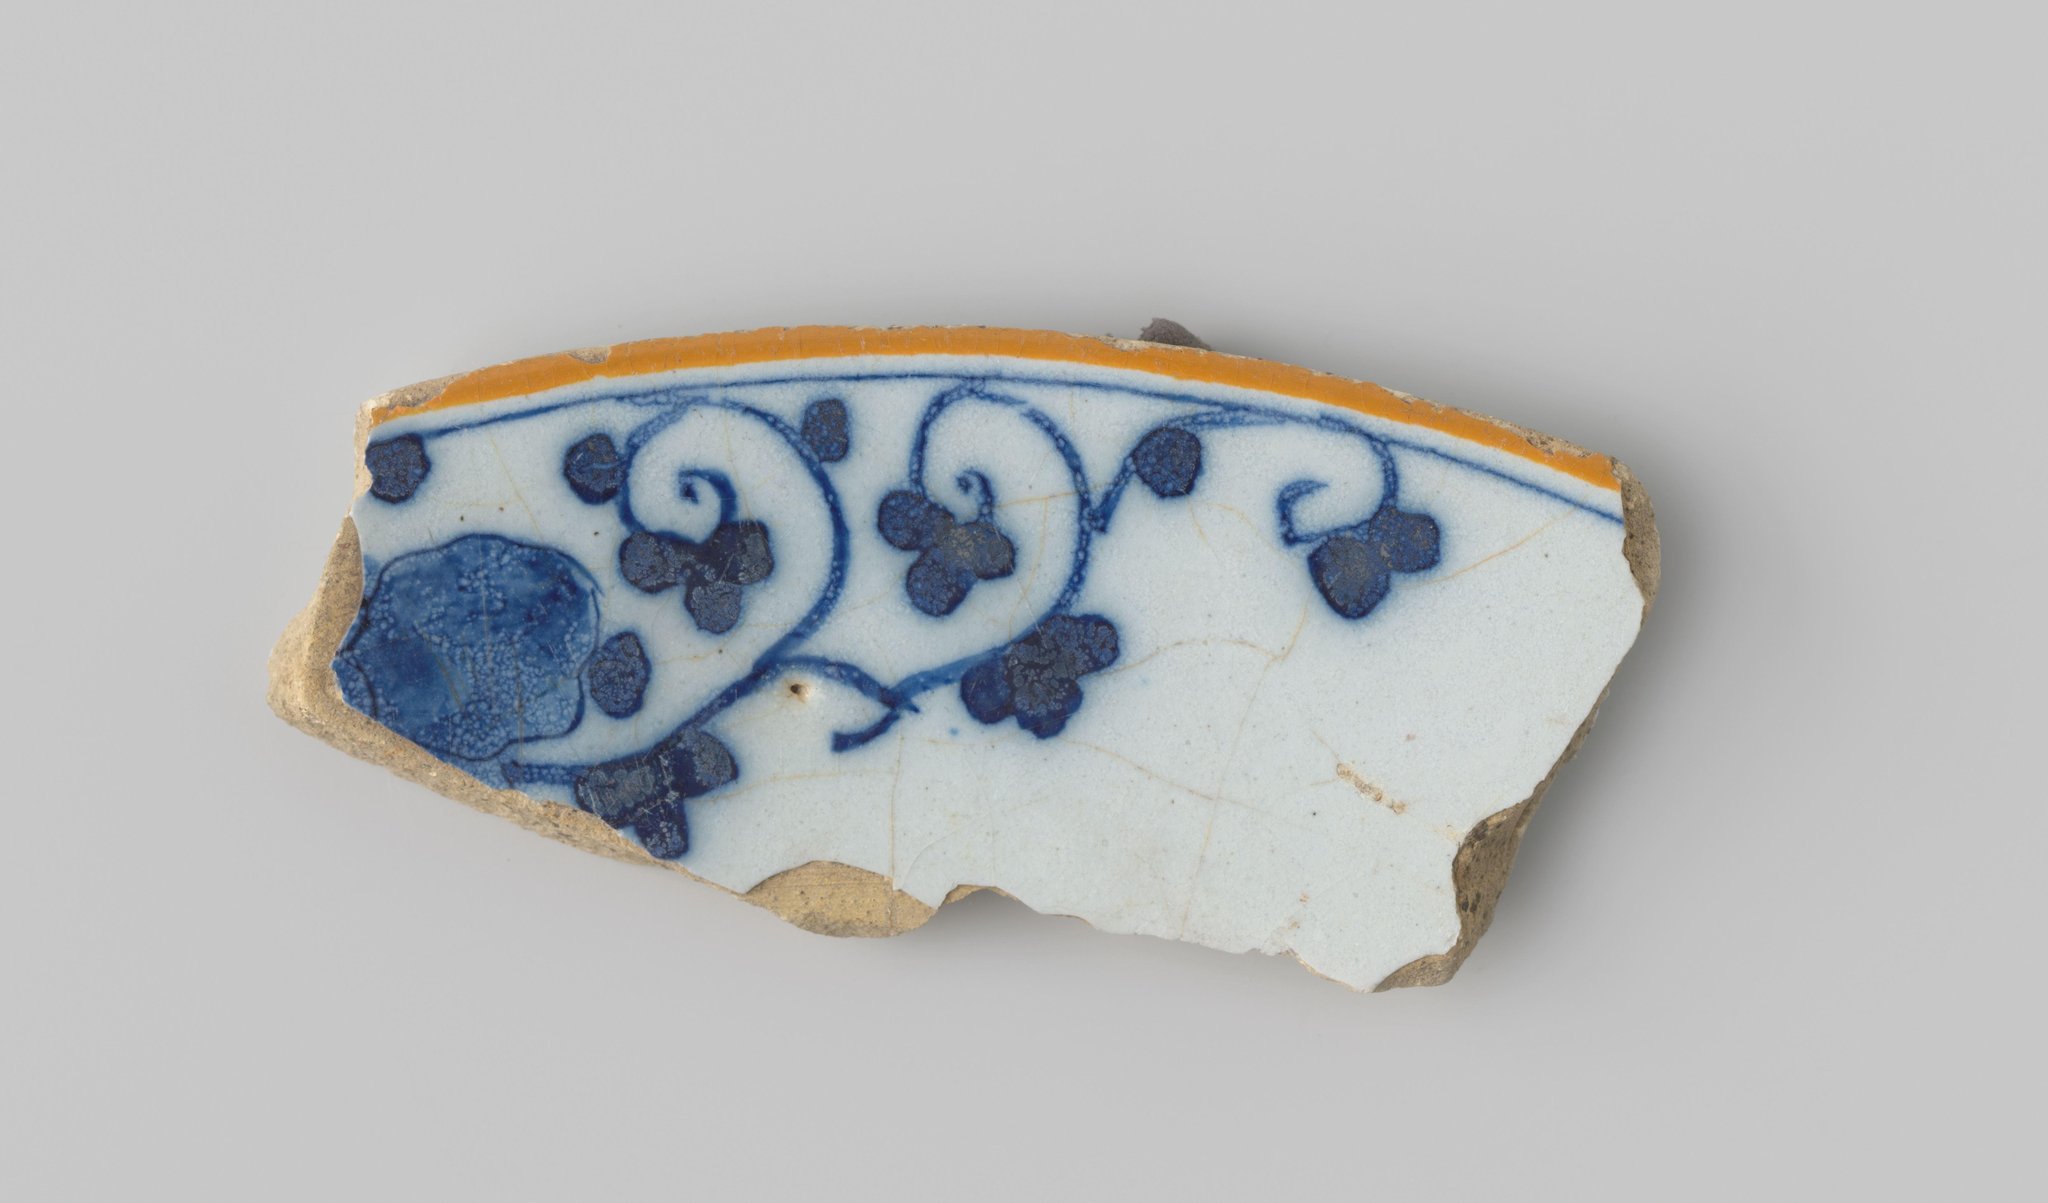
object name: sherd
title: Scherf van witbakkend aardewerk, aan de bovenzijde voorzien van een beschildering van bloemvormen in blauw op een witte ondergrond, met een oranje rand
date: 1500-1899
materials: earthenware, glaze